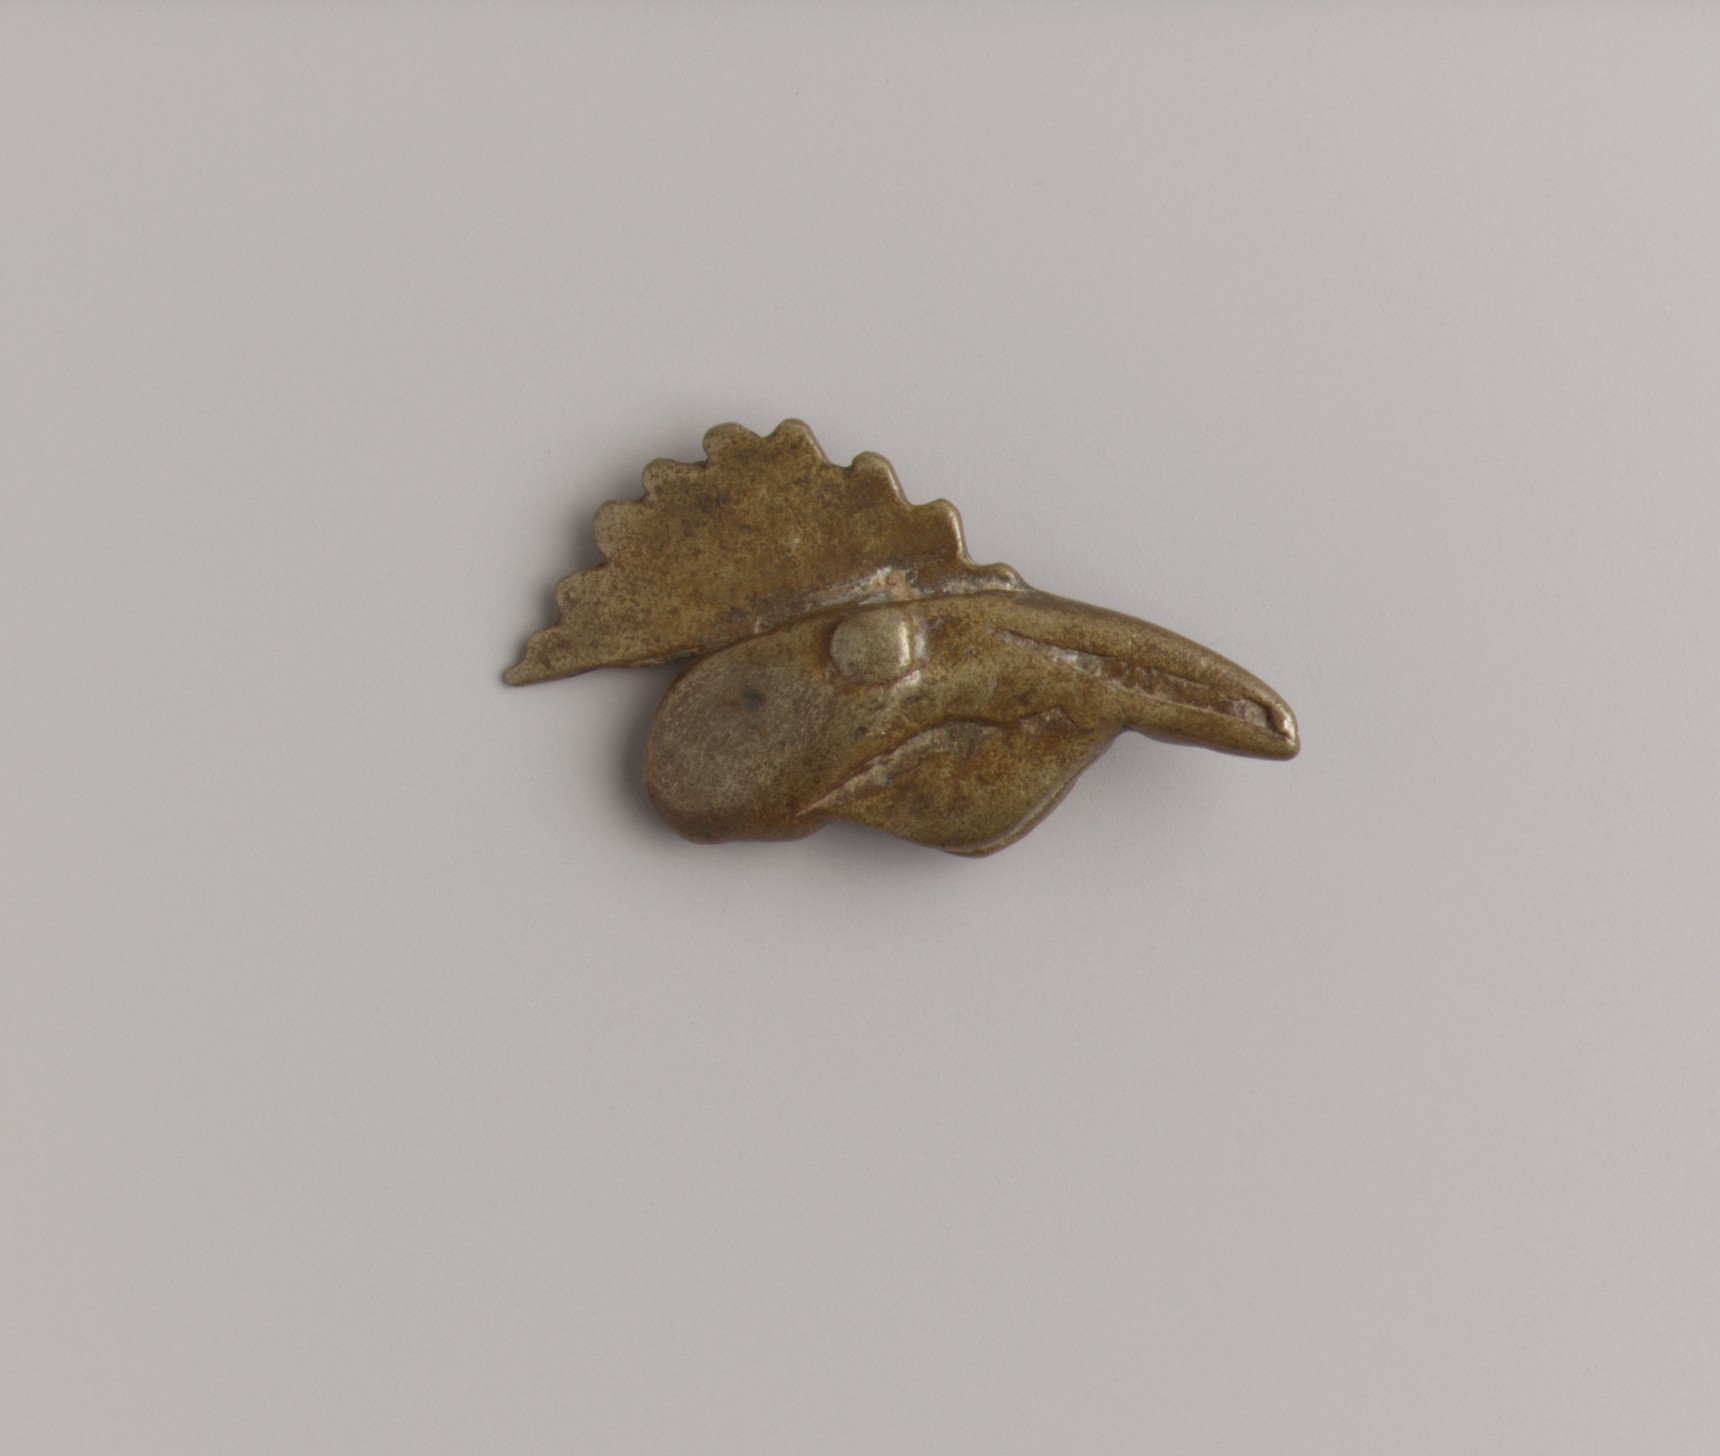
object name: weight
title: Chicken's head gold weight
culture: akan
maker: akan artist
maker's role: artist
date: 1701-1900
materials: brass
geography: ghana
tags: chickens